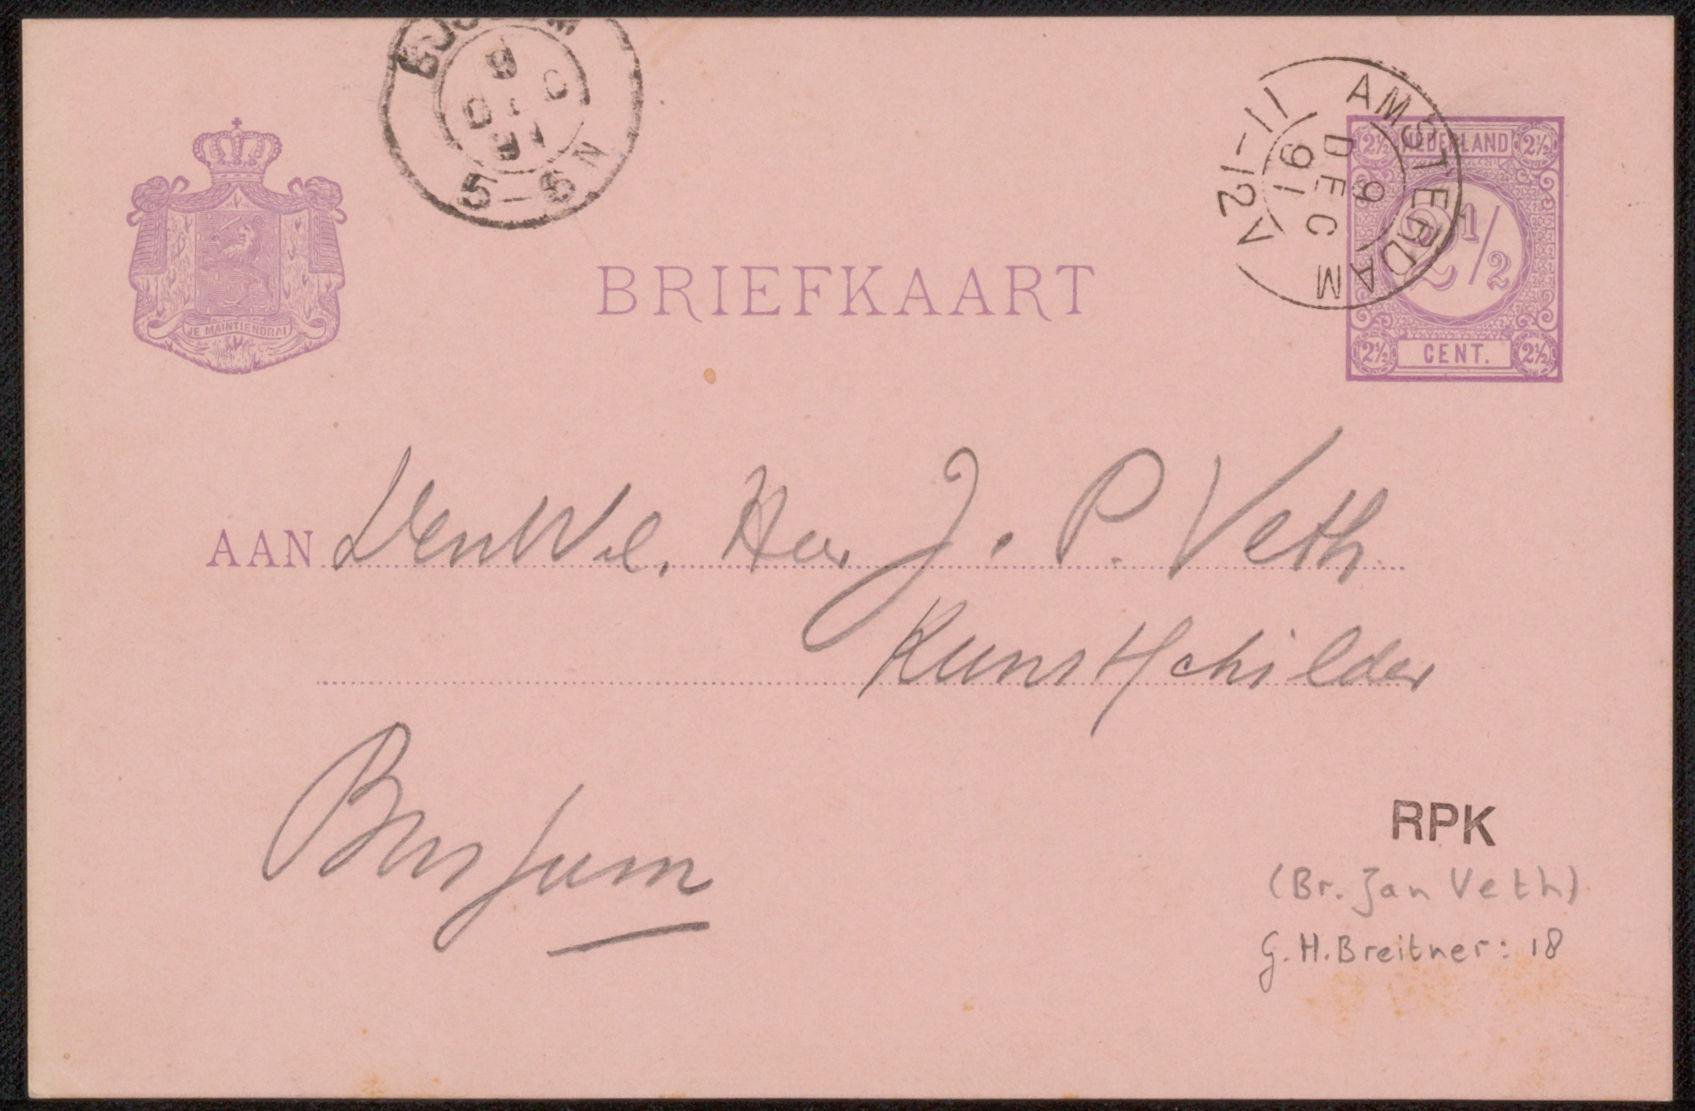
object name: postcard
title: Brief aan Jan Veth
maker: george hendrik breitner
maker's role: draughtsman, painter, print maker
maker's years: 1857-1923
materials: cardboard, pencil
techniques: writing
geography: amsterdam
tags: dordrecht, designer, jan veth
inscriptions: collector's mark: ‘RPK’